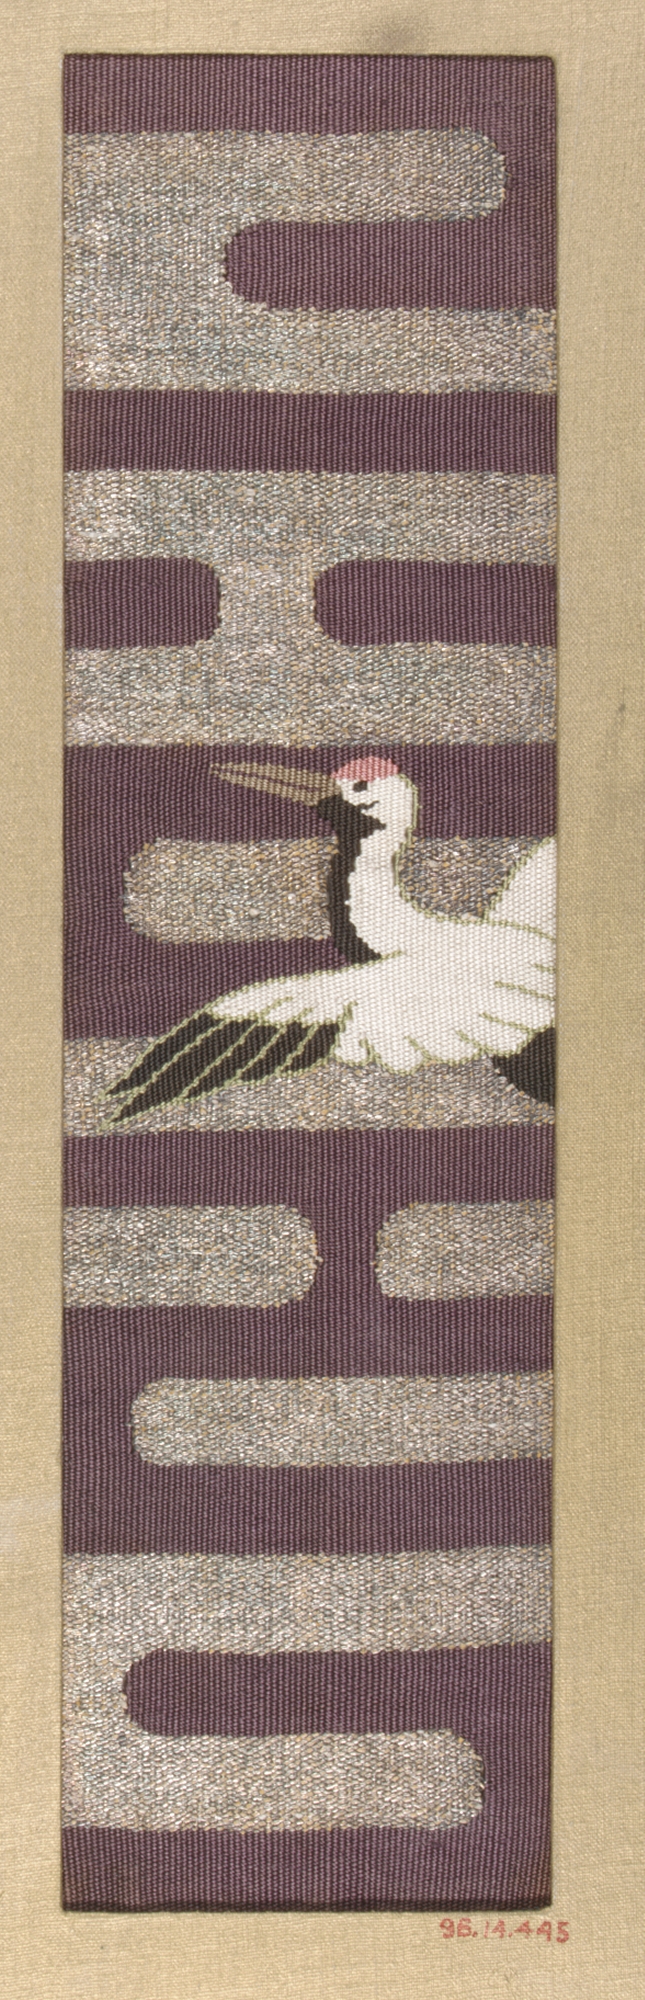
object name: piece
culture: japanese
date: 1701-1900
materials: silk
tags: cranes